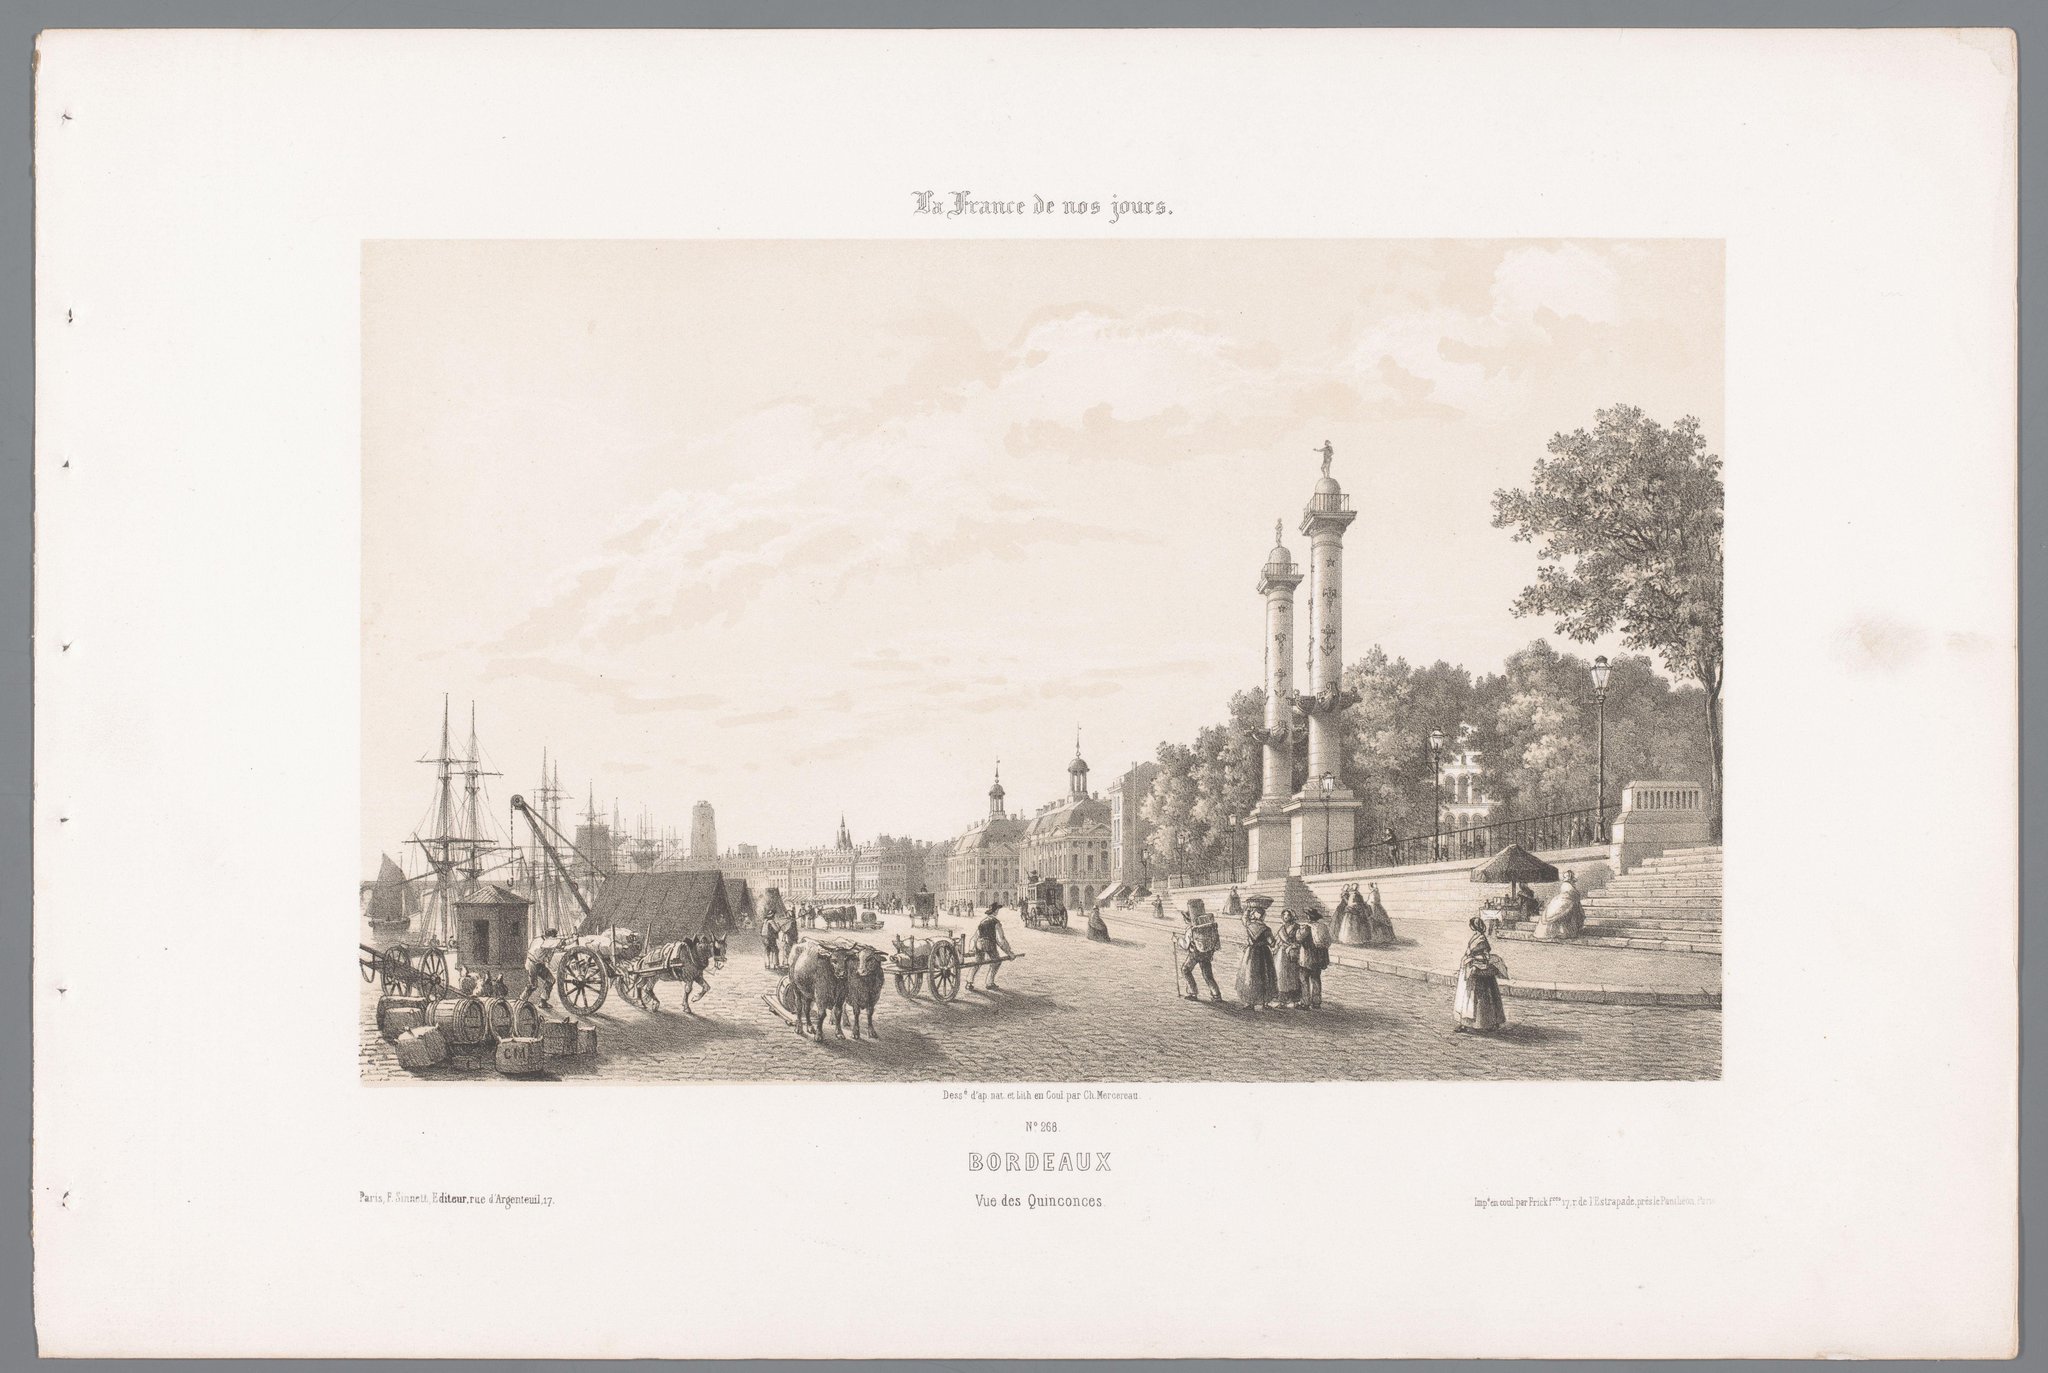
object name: print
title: Bordeaux, vue des Quinconces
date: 1856-1874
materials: paper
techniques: tone lithography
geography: paris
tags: square, place, circus, etc., city-view, and landscape with man-made constructions, trade, commerce and finance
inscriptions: collector's mark: Lugt 2228